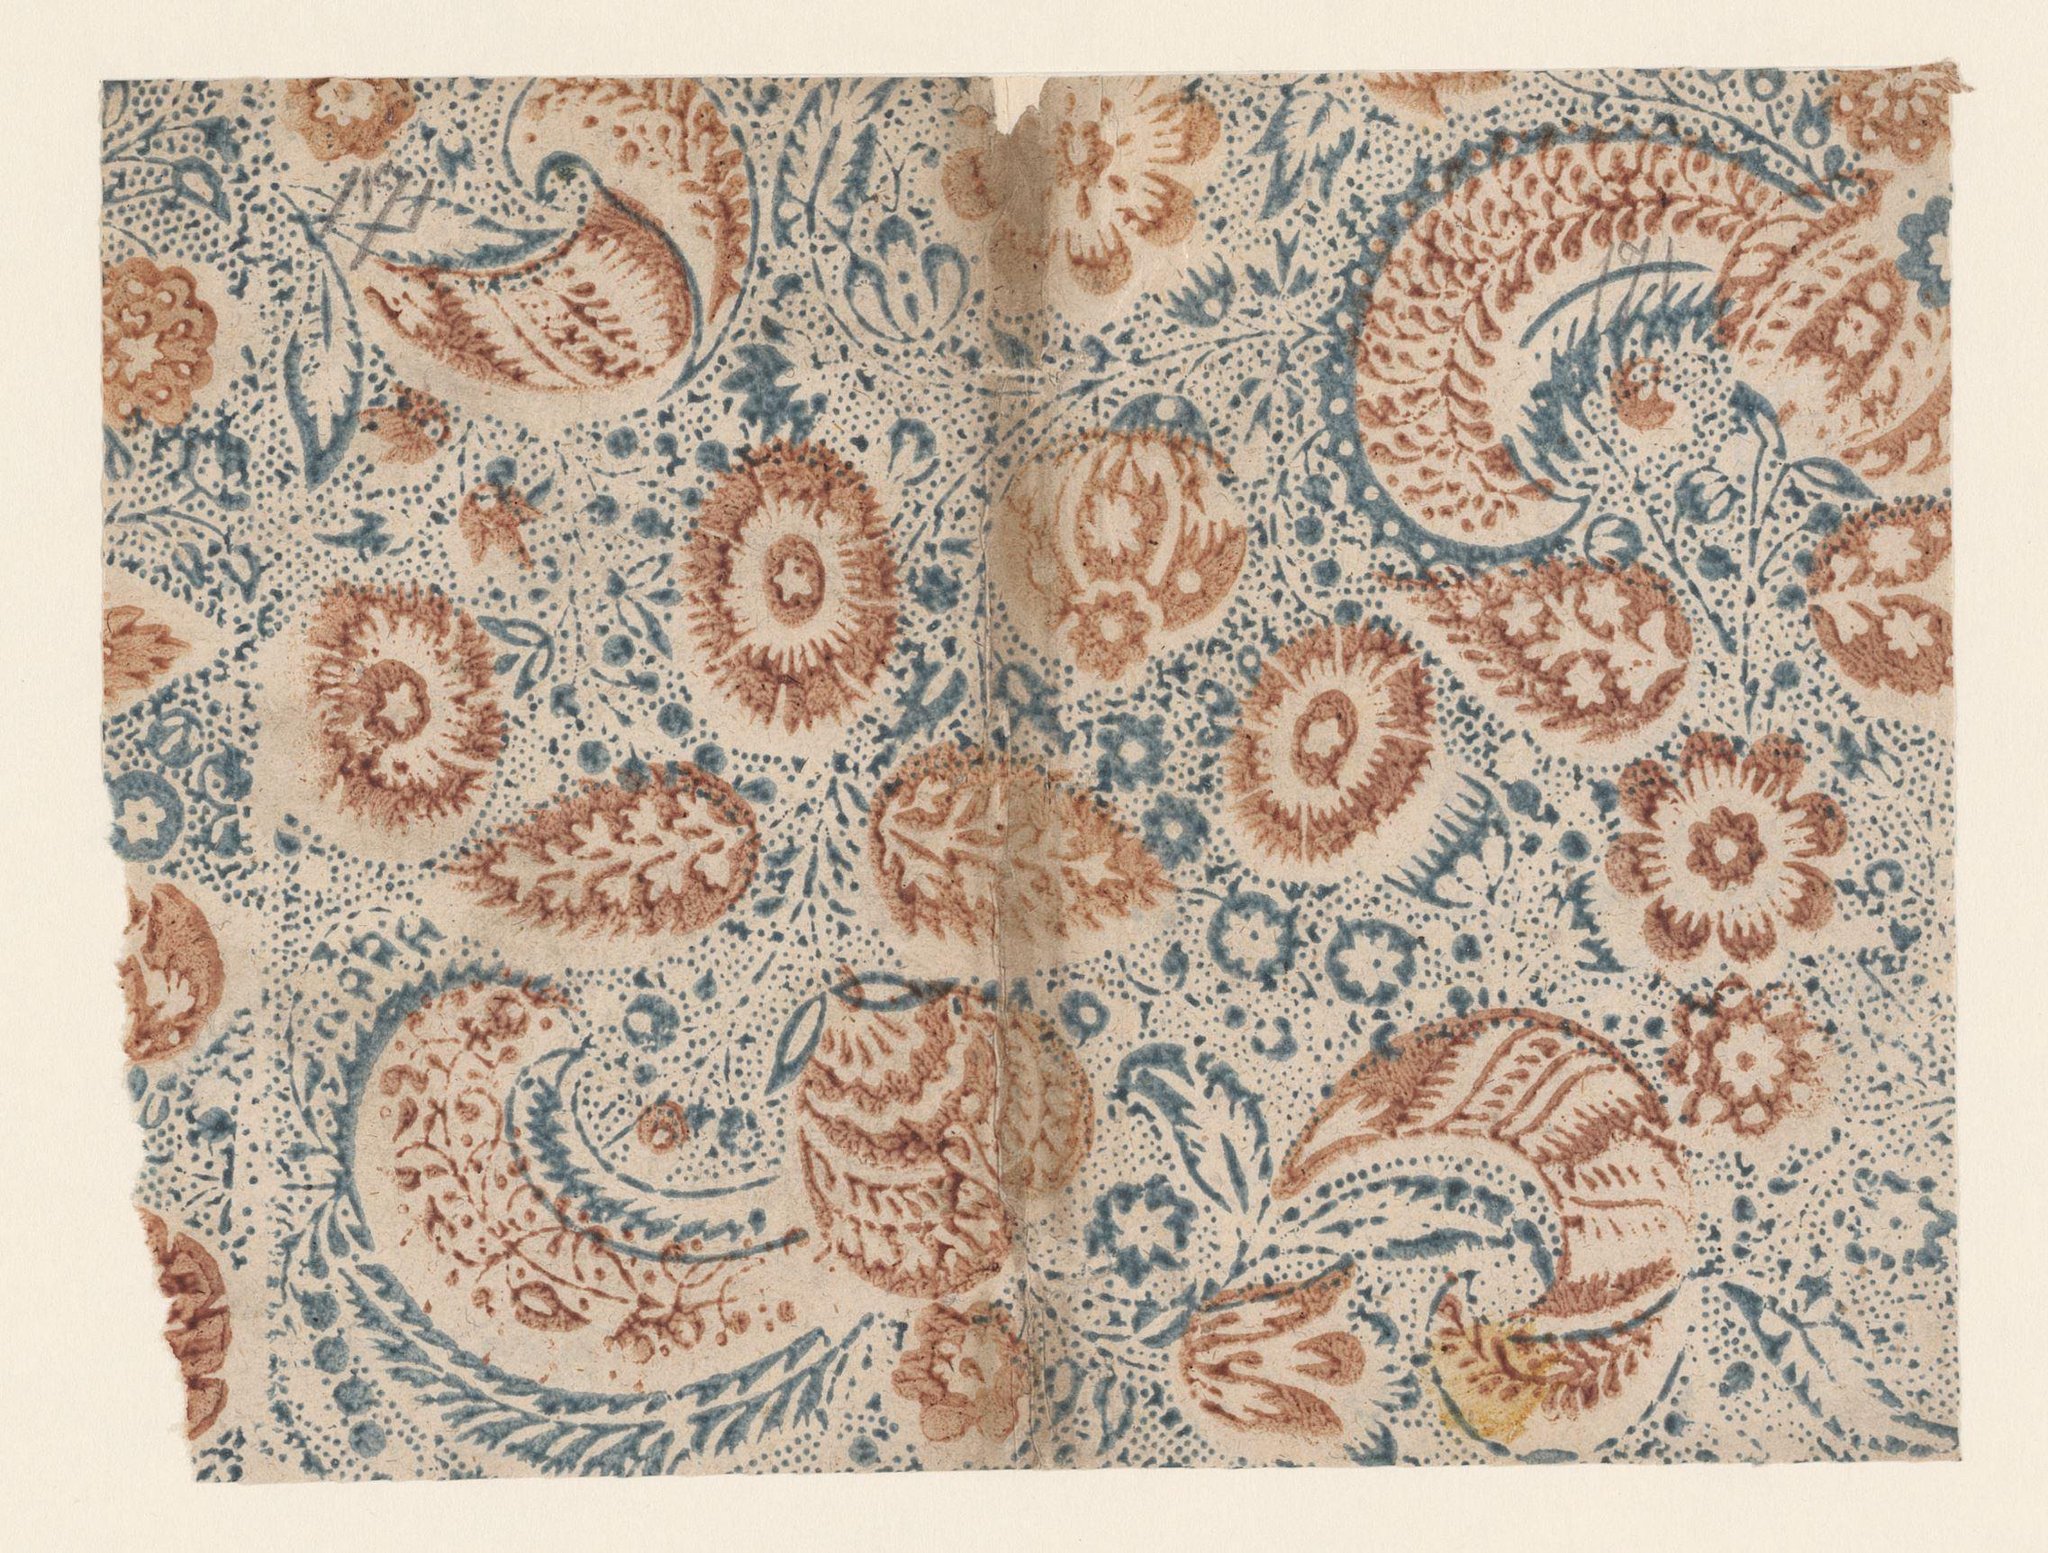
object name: printed paper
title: Blad met strooipatroon van bloemen en paisleymotieven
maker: Anonymous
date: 1720-1760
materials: paper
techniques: printing block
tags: ornament derived from plant forms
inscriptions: annotation: ‘Borle Polyxena Amst. 1740’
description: Blad met strooipatroon van bloemen en paisleyachtige motieven, op een fond van punten en kleine bloemen. Gebruikt als omslag voor een publicatie uit 1740.